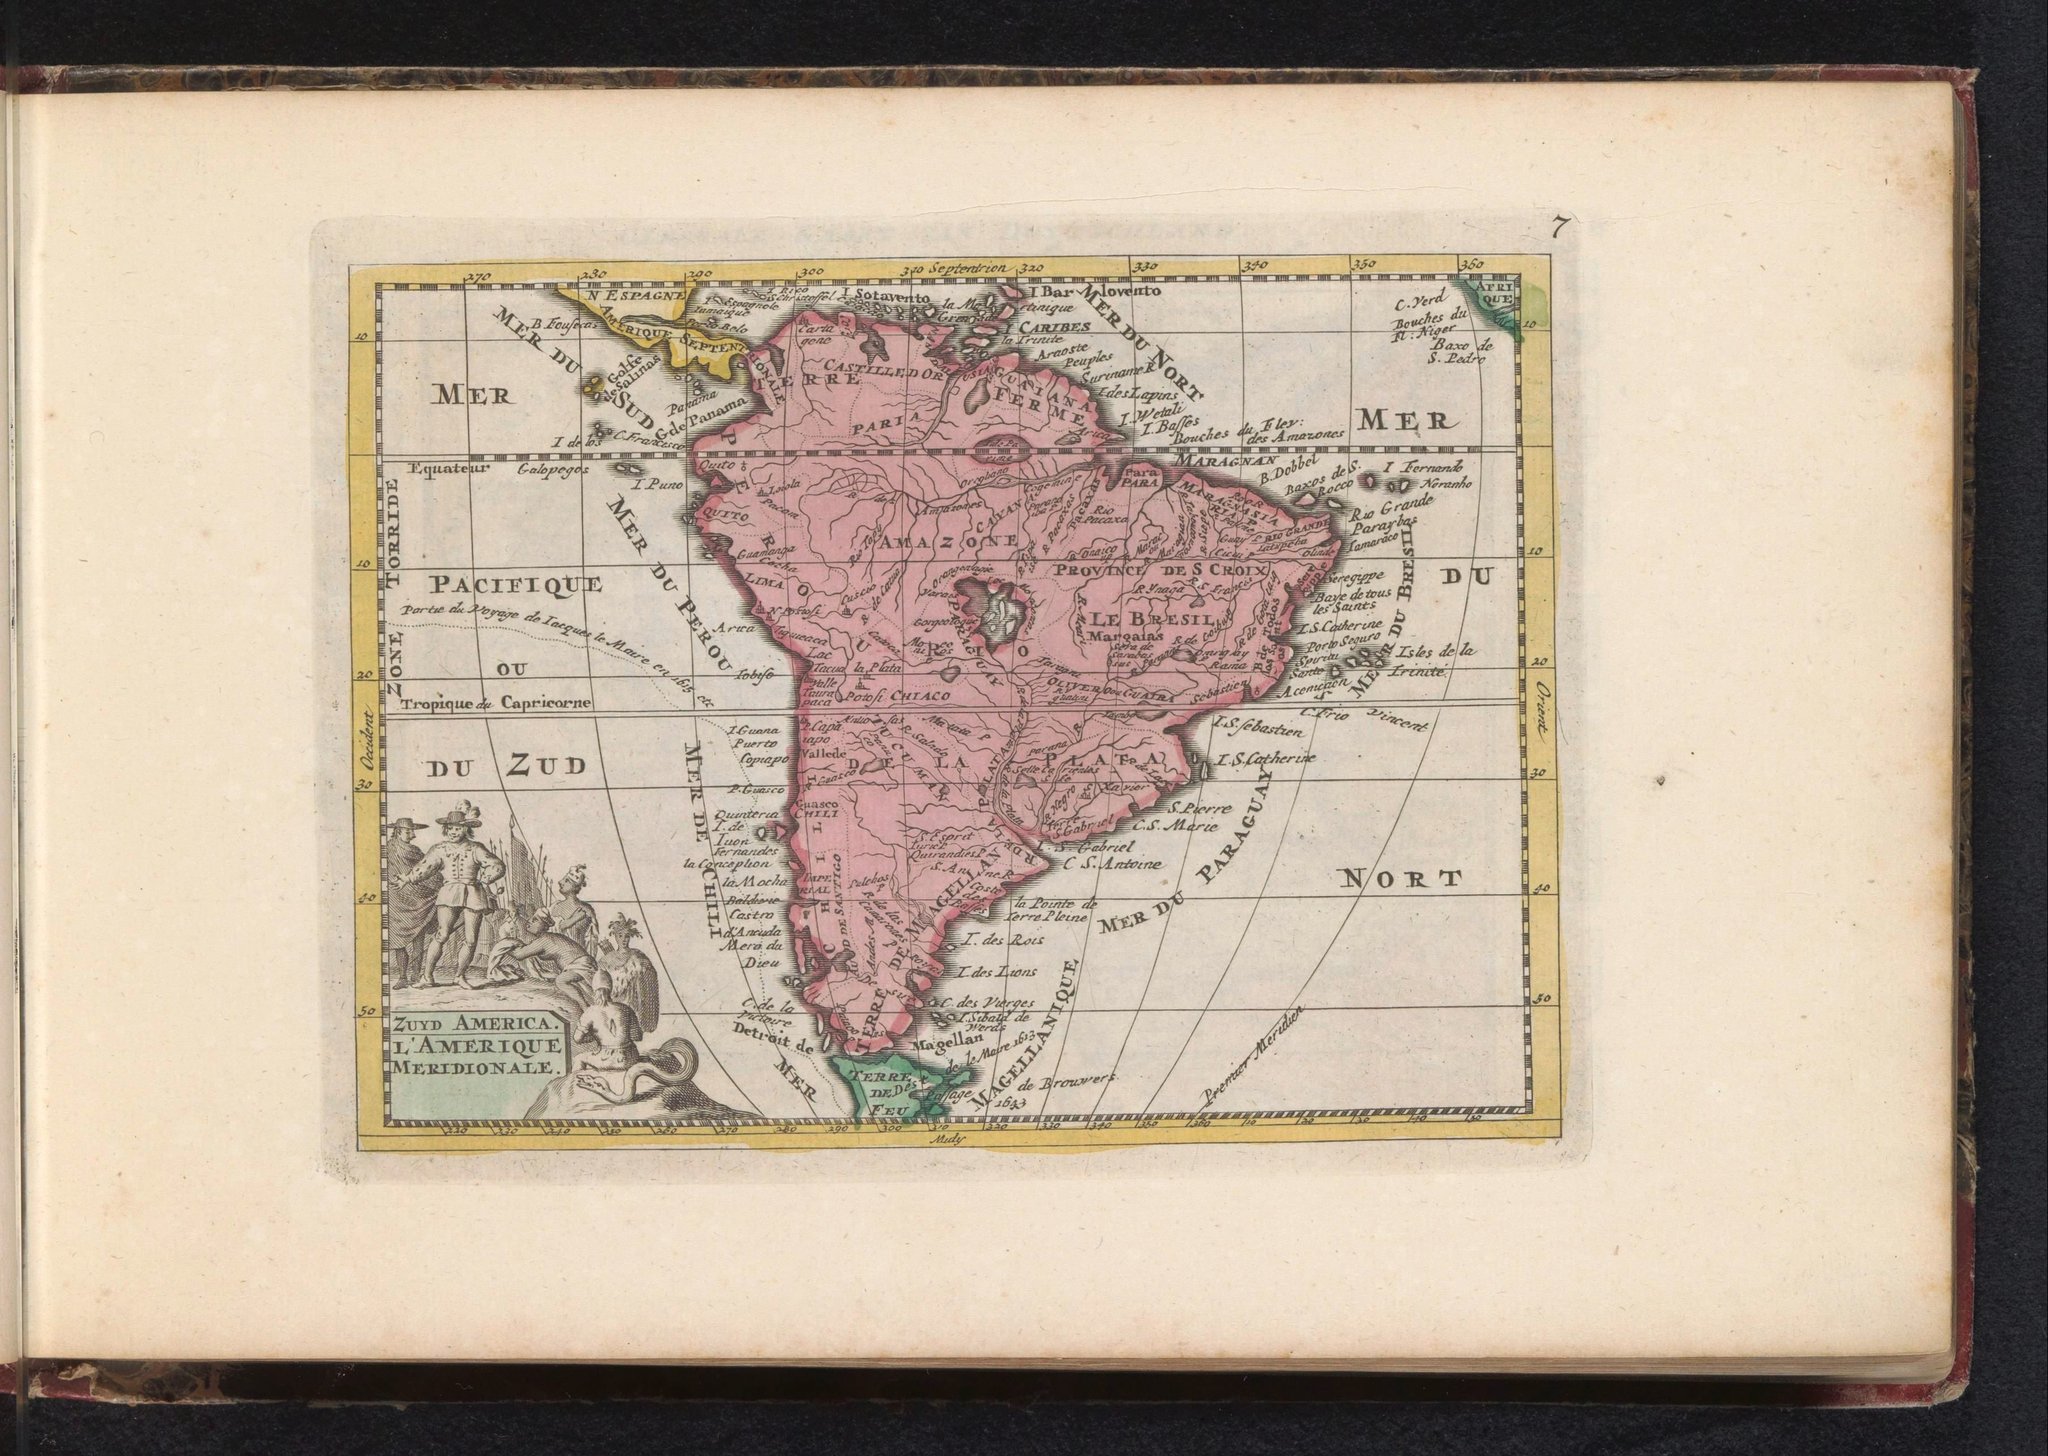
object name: map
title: Kaart van Zuid-Amerika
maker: Anonymous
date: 1700-1705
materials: paper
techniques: engraving, hand coloring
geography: northern netherlands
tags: (map of) south america, indigenous peoples of south america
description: Kaart van Zuid-Amerika, linksonder een vignet met oorspronkelijke bewoners van Zuid-Amerika die knielen voor Europeanen. Onderdeel van een atlas met 223 kaarten van landen en steden en oorlogstaferelen in Europa in de periode ca. 1690-1735.